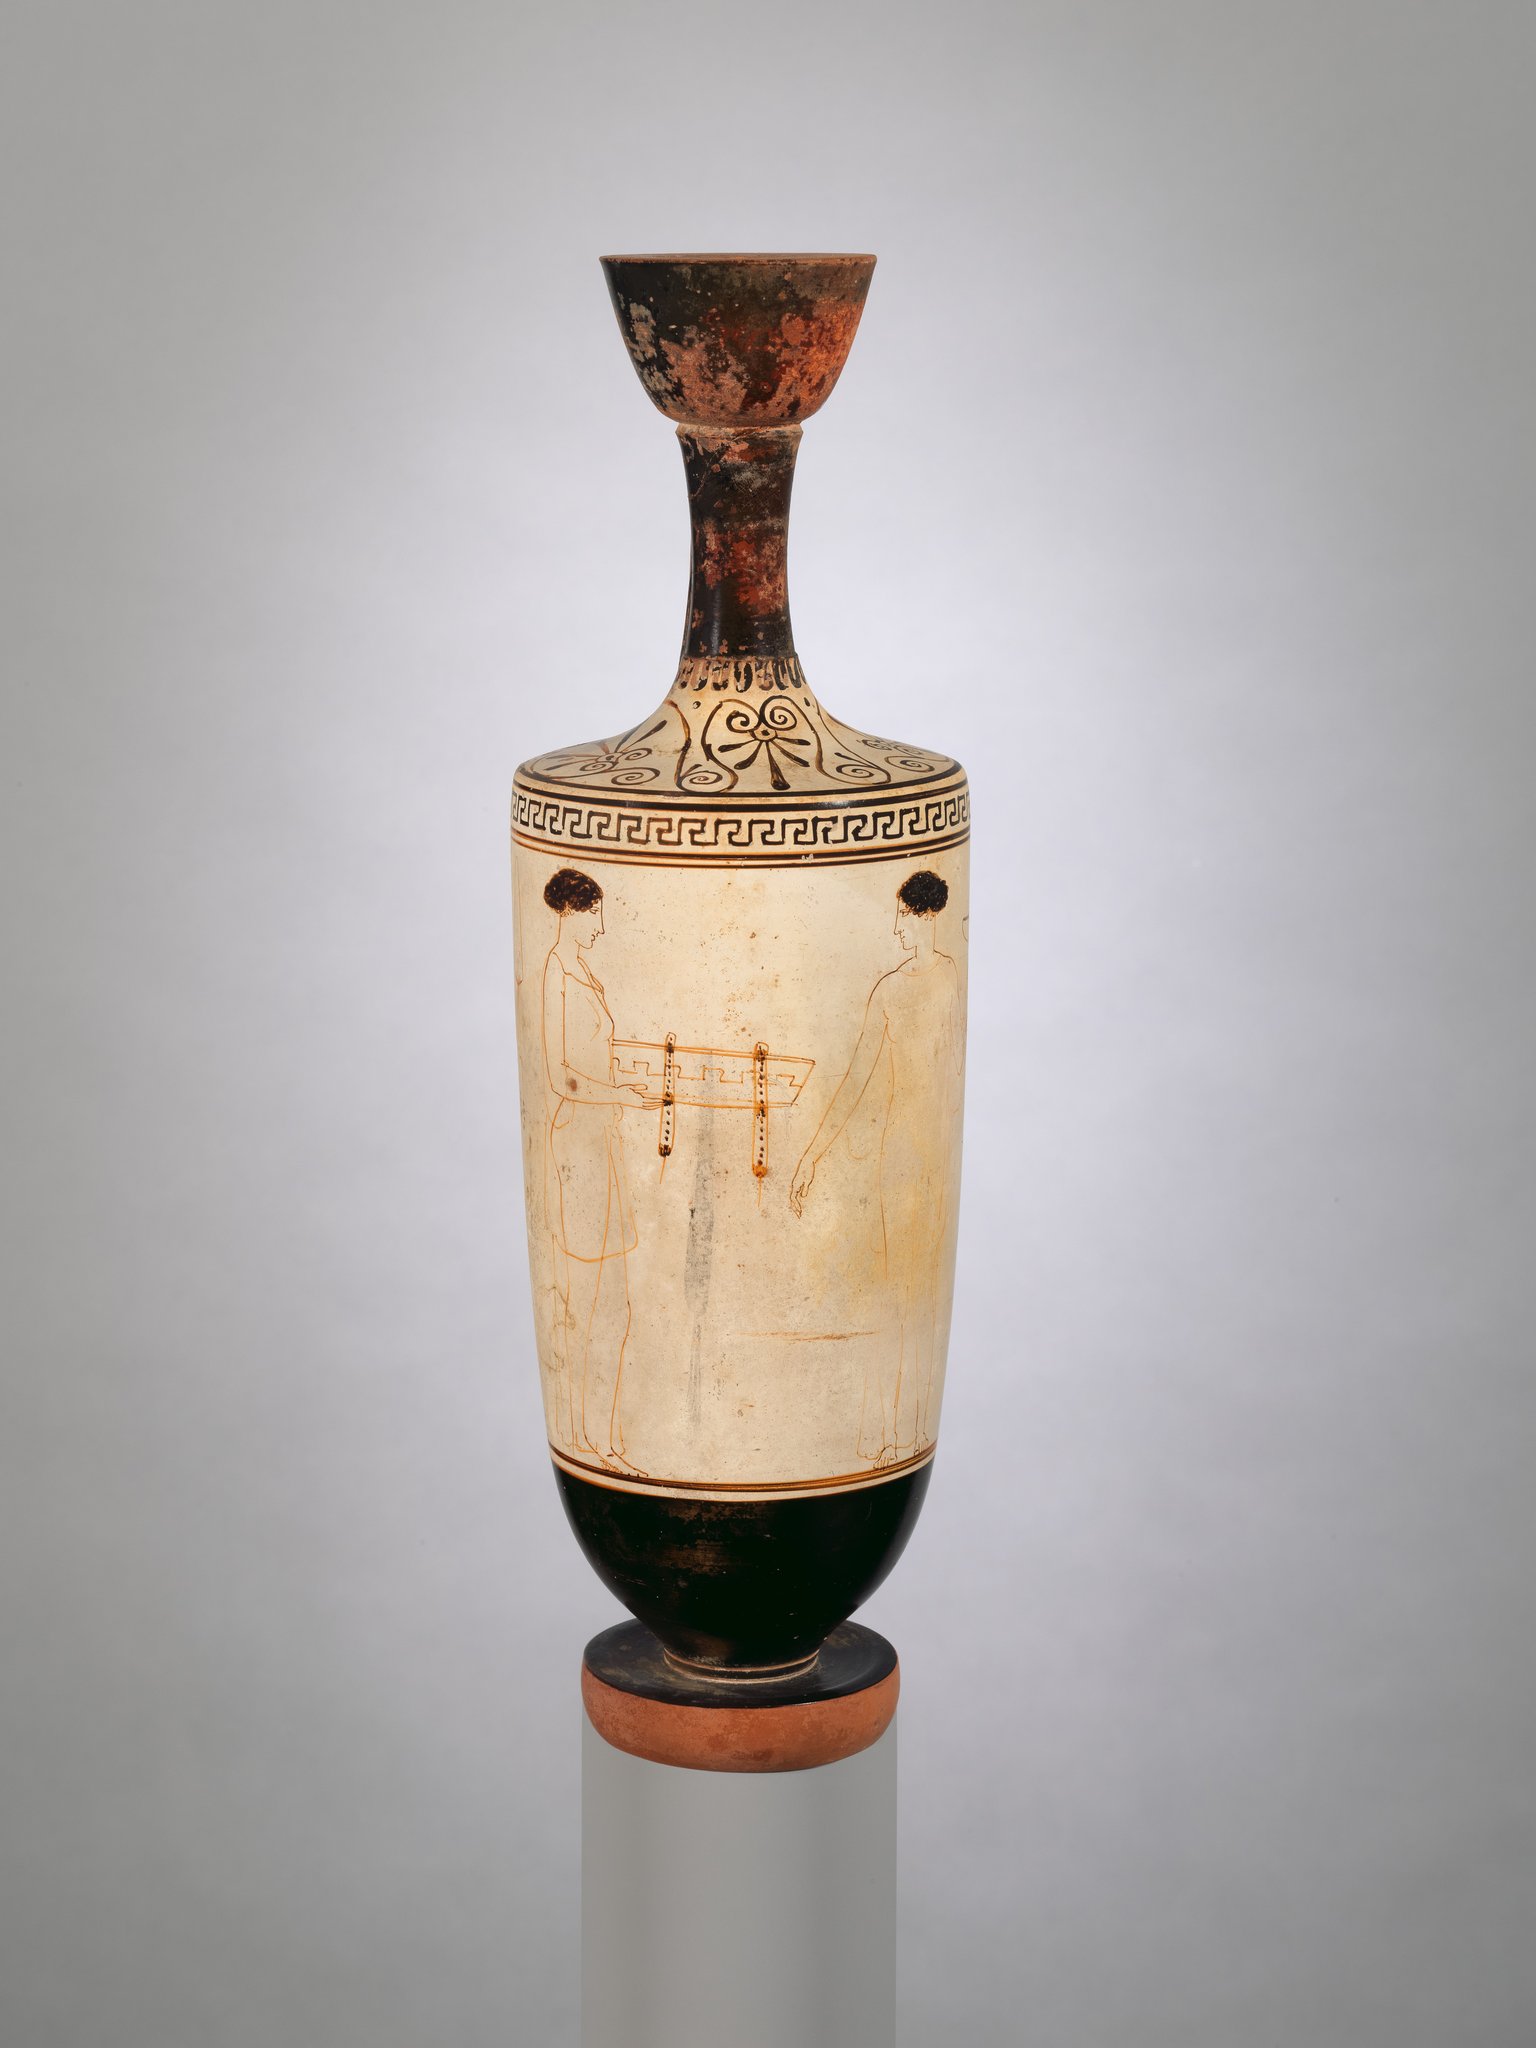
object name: lekythos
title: Terracotta lekythos (oil flask)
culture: greek, attic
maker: achilles painter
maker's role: artist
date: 450 BCE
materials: terracotta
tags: women